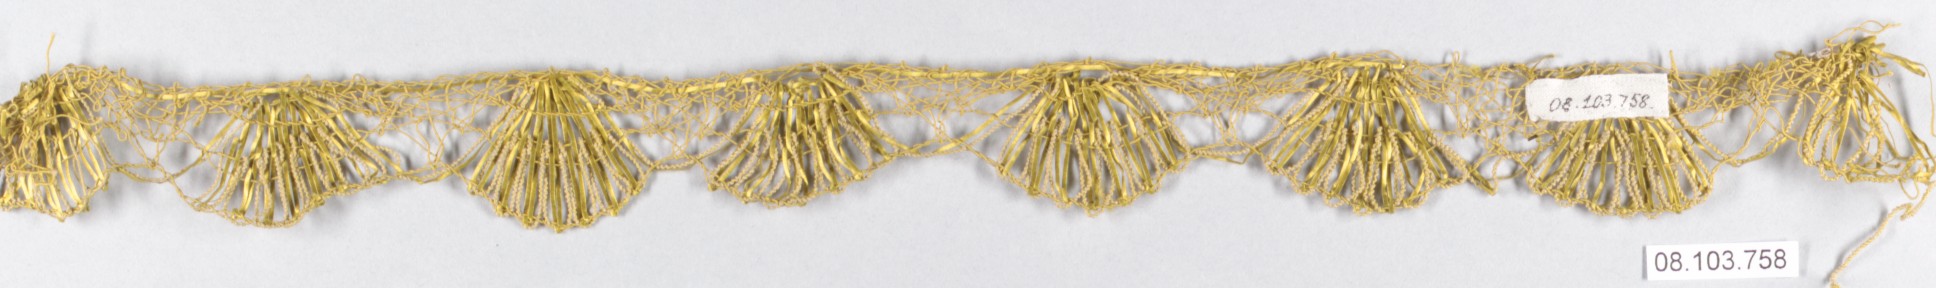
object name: gimp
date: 1701-1900